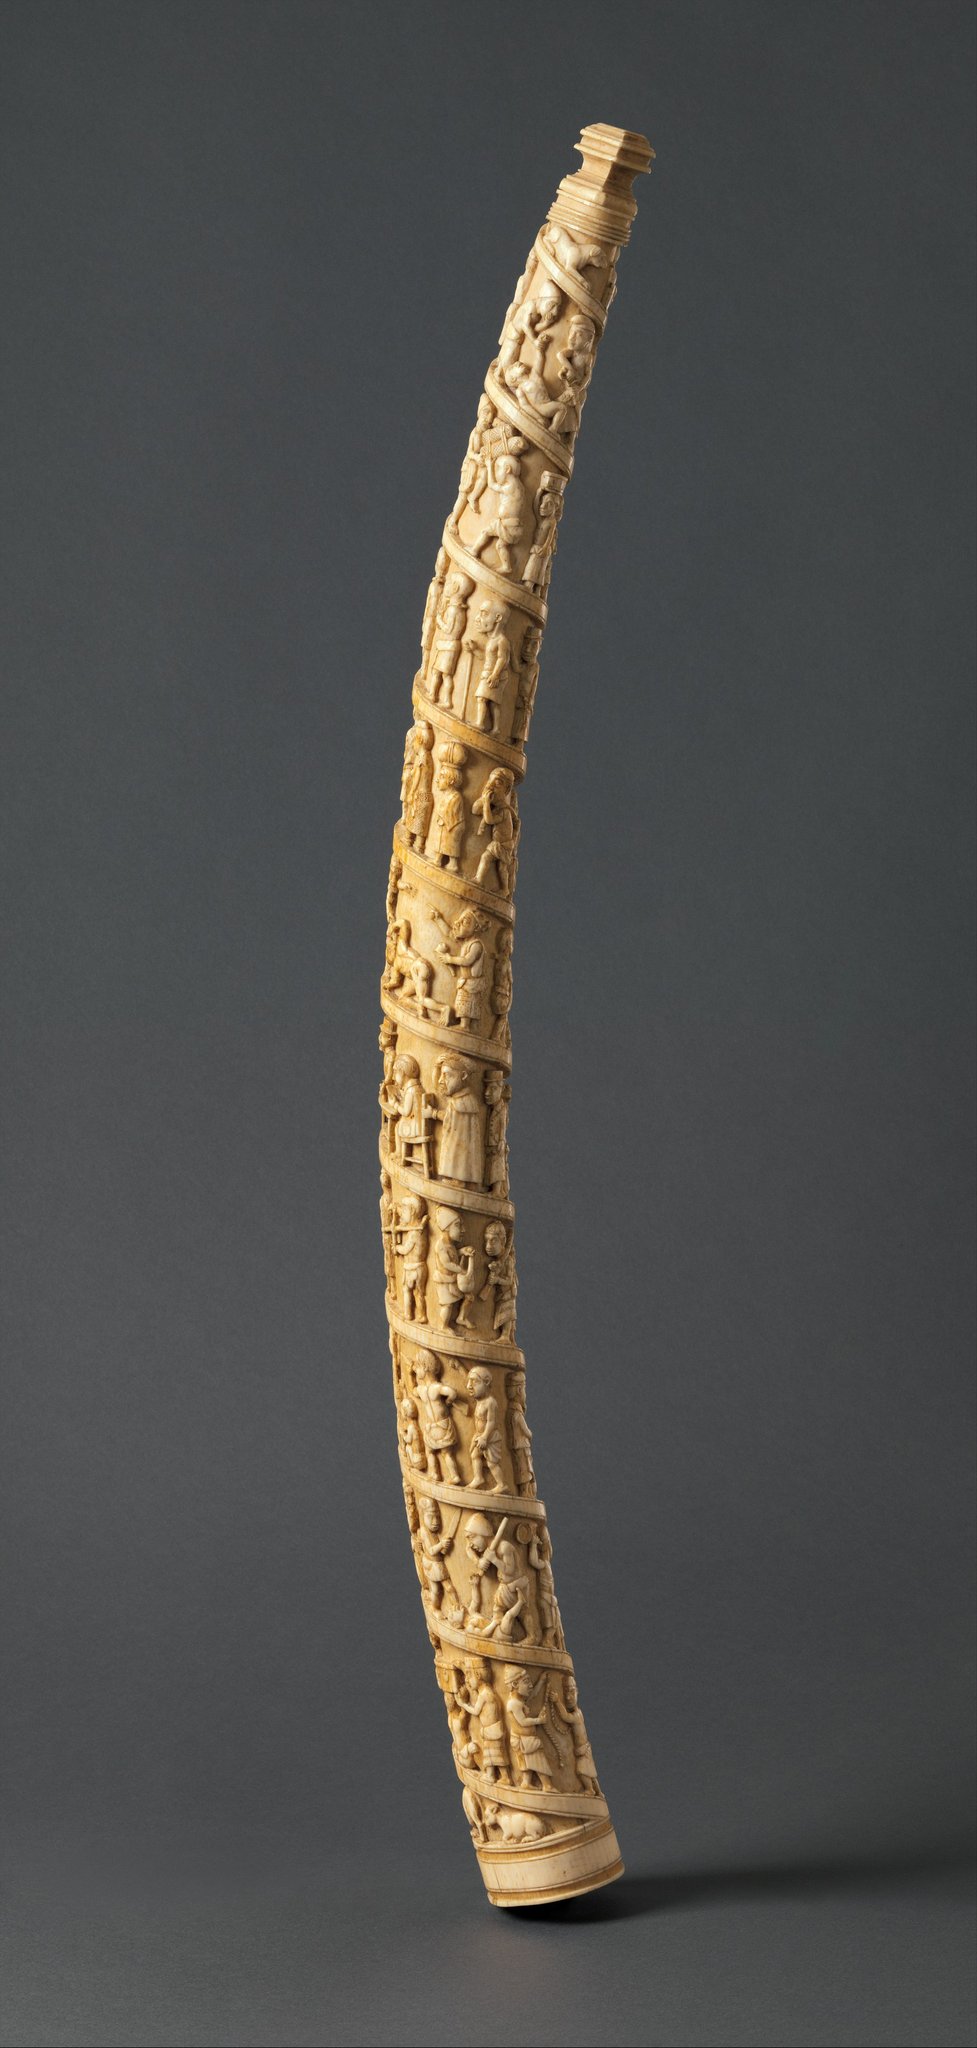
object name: tusk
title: Tusk with figurative relief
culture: kongo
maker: vili-kongo artist(s)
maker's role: artist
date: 1880-1890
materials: ivory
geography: cabinda